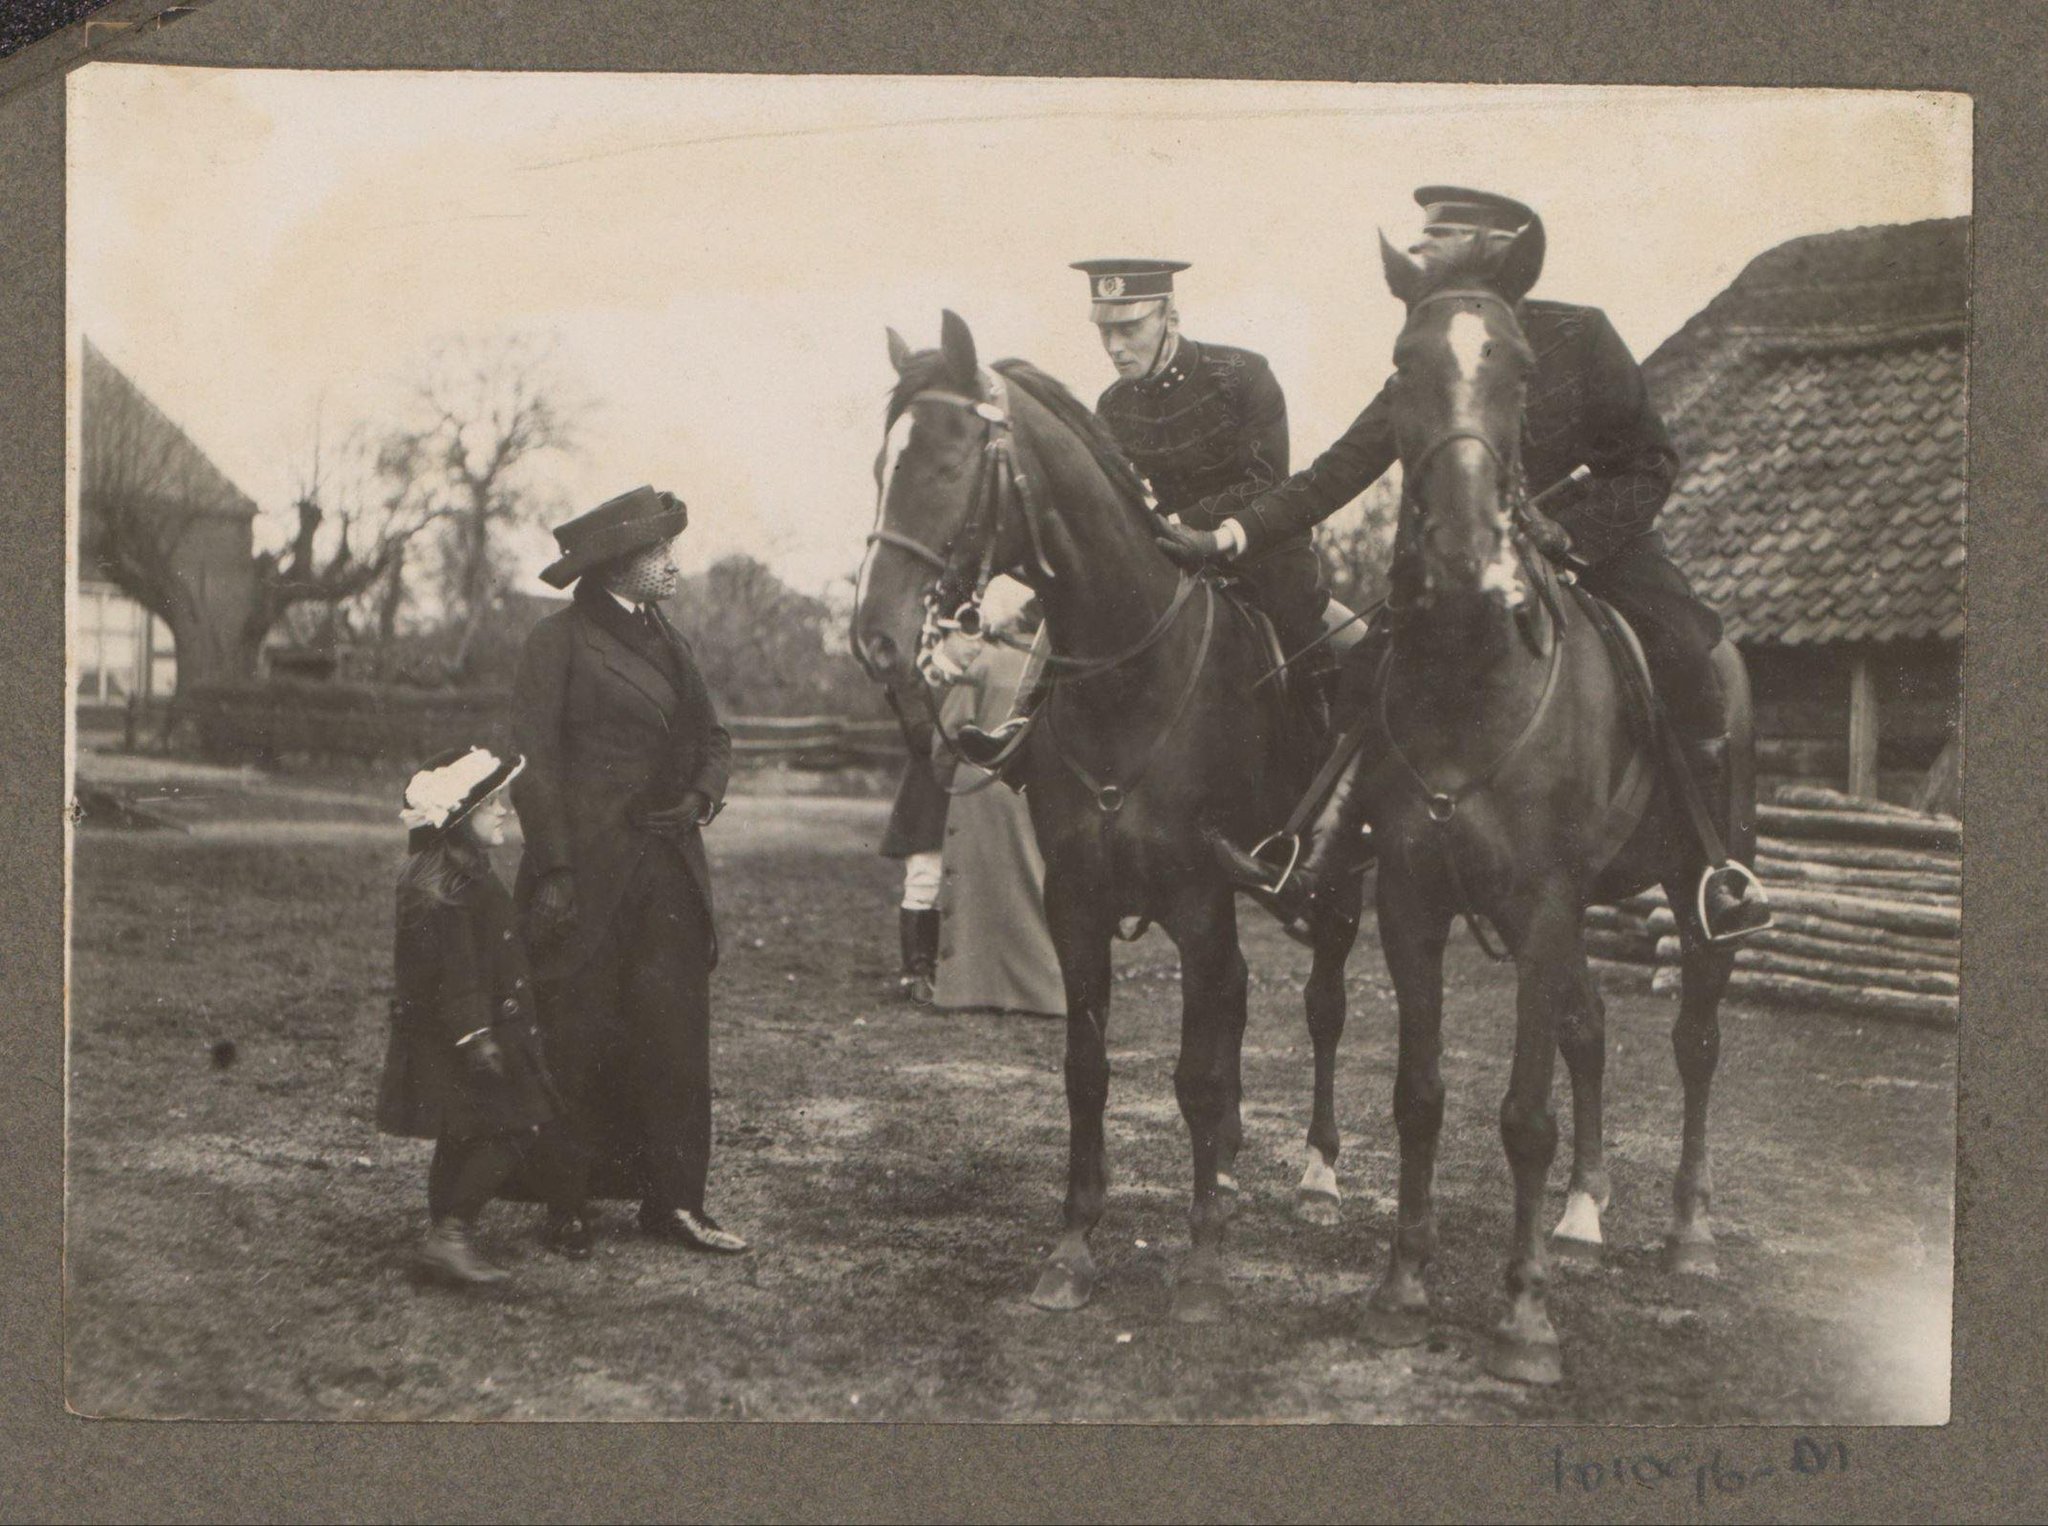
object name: album leaf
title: Vrouw met kind bij twee ruiters, vermoedelijk op Koninklijke Houtvesterij Het Loo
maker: Anonymous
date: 1900-1925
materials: photographic support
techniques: gelatin silver print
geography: het loo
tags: riding a horse, ass, or mule; rider, horseman, hunting, chase, hunting-ground, mother and baby or young child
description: Onderdeel van Fotoalbum van de heer Brams, opperhoutvester van koningin Wilhelmina op Koninklijke Houtvesterij Het Loo.